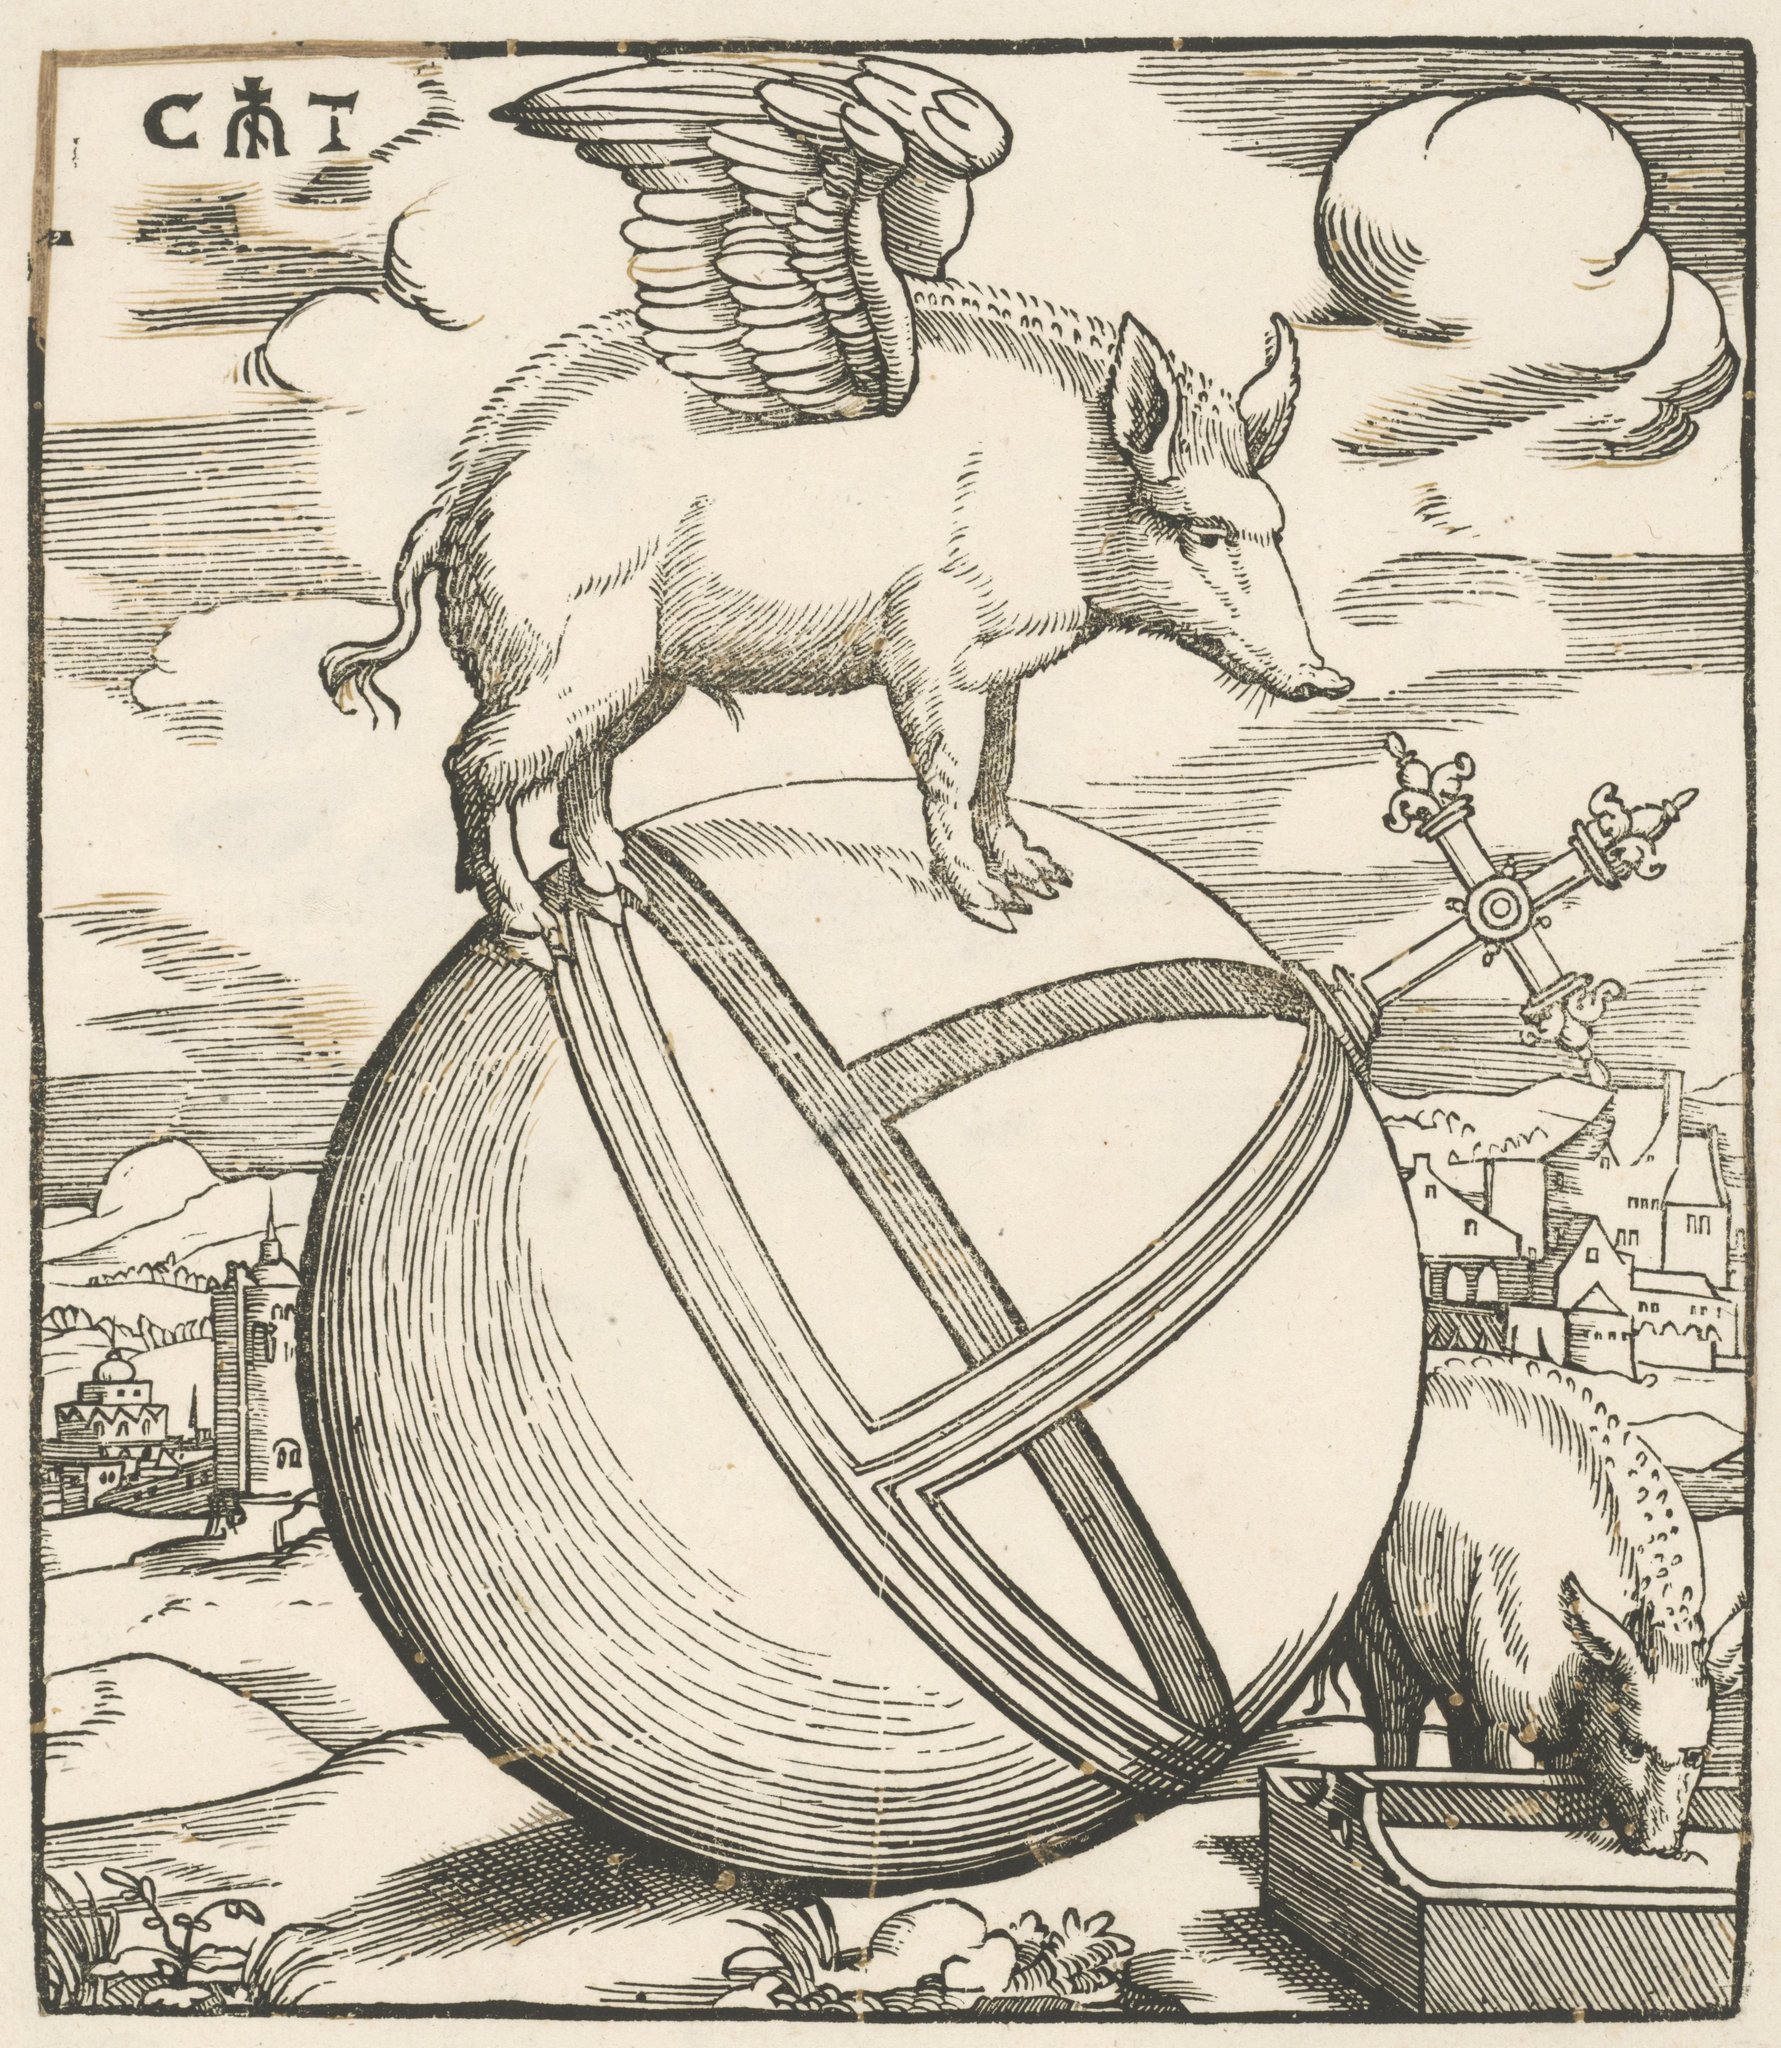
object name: print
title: Het gevleugelde varken op de wereld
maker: cornelis anthonisz.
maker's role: draughtsman, painter, print maker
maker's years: 1499-1553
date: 1541-1545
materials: paper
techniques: pen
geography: low countries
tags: pig, corruptibility, venality, corruption, globe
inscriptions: collector's mark: Lugt 240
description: Allegorie op de corrupte wereld: gevleugeld varken staand op rijksappel. Tweede varken etend uit trog.